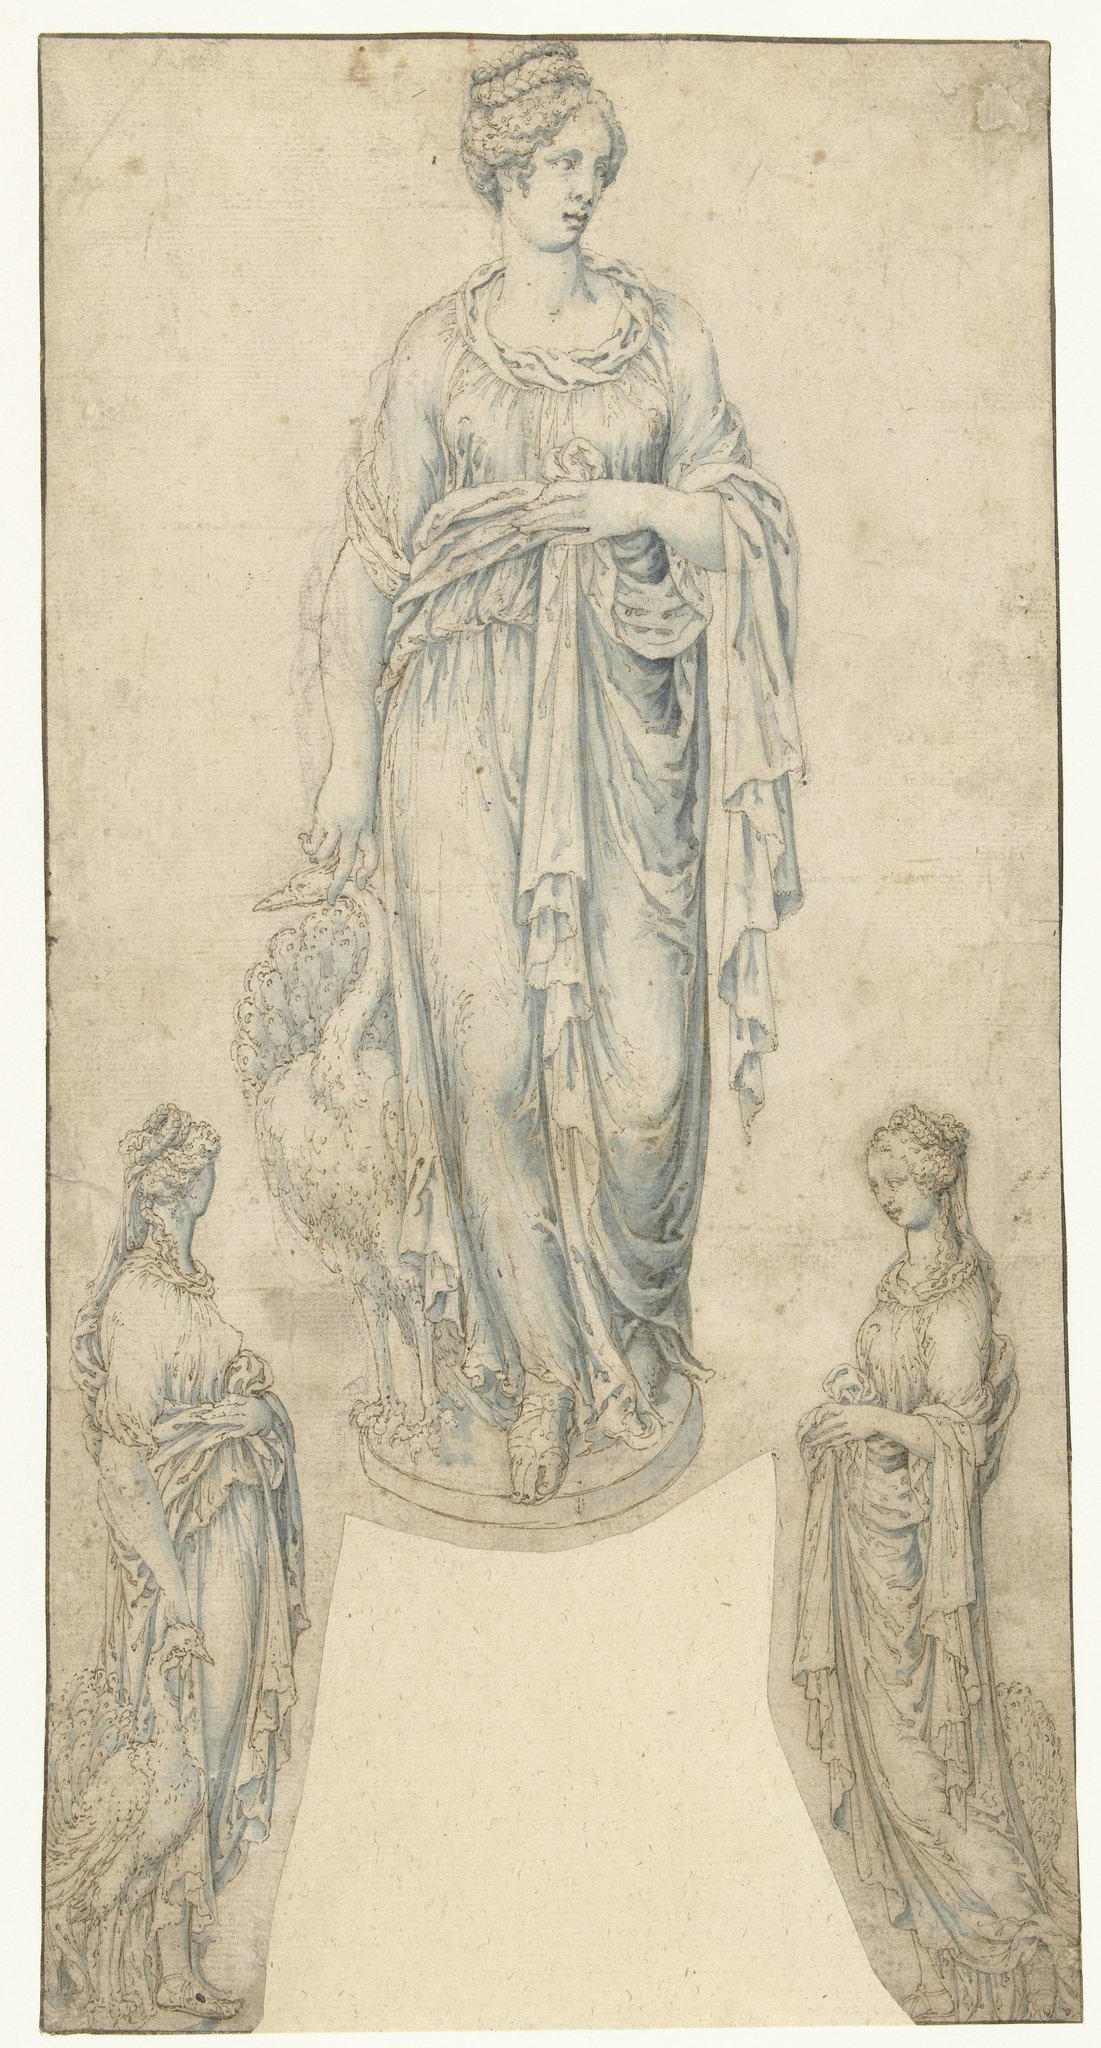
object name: drawing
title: Drie studies naar of voor een beeldje van Juno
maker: vincent sellaer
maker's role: draughtsman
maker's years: 1490-1544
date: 1538-1544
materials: chalk, ink, paper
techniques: brush, pen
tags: (story of) juno (hera), piece of sculpture, reproduction of a piece of sculpture, standing figure - aa - female human figure